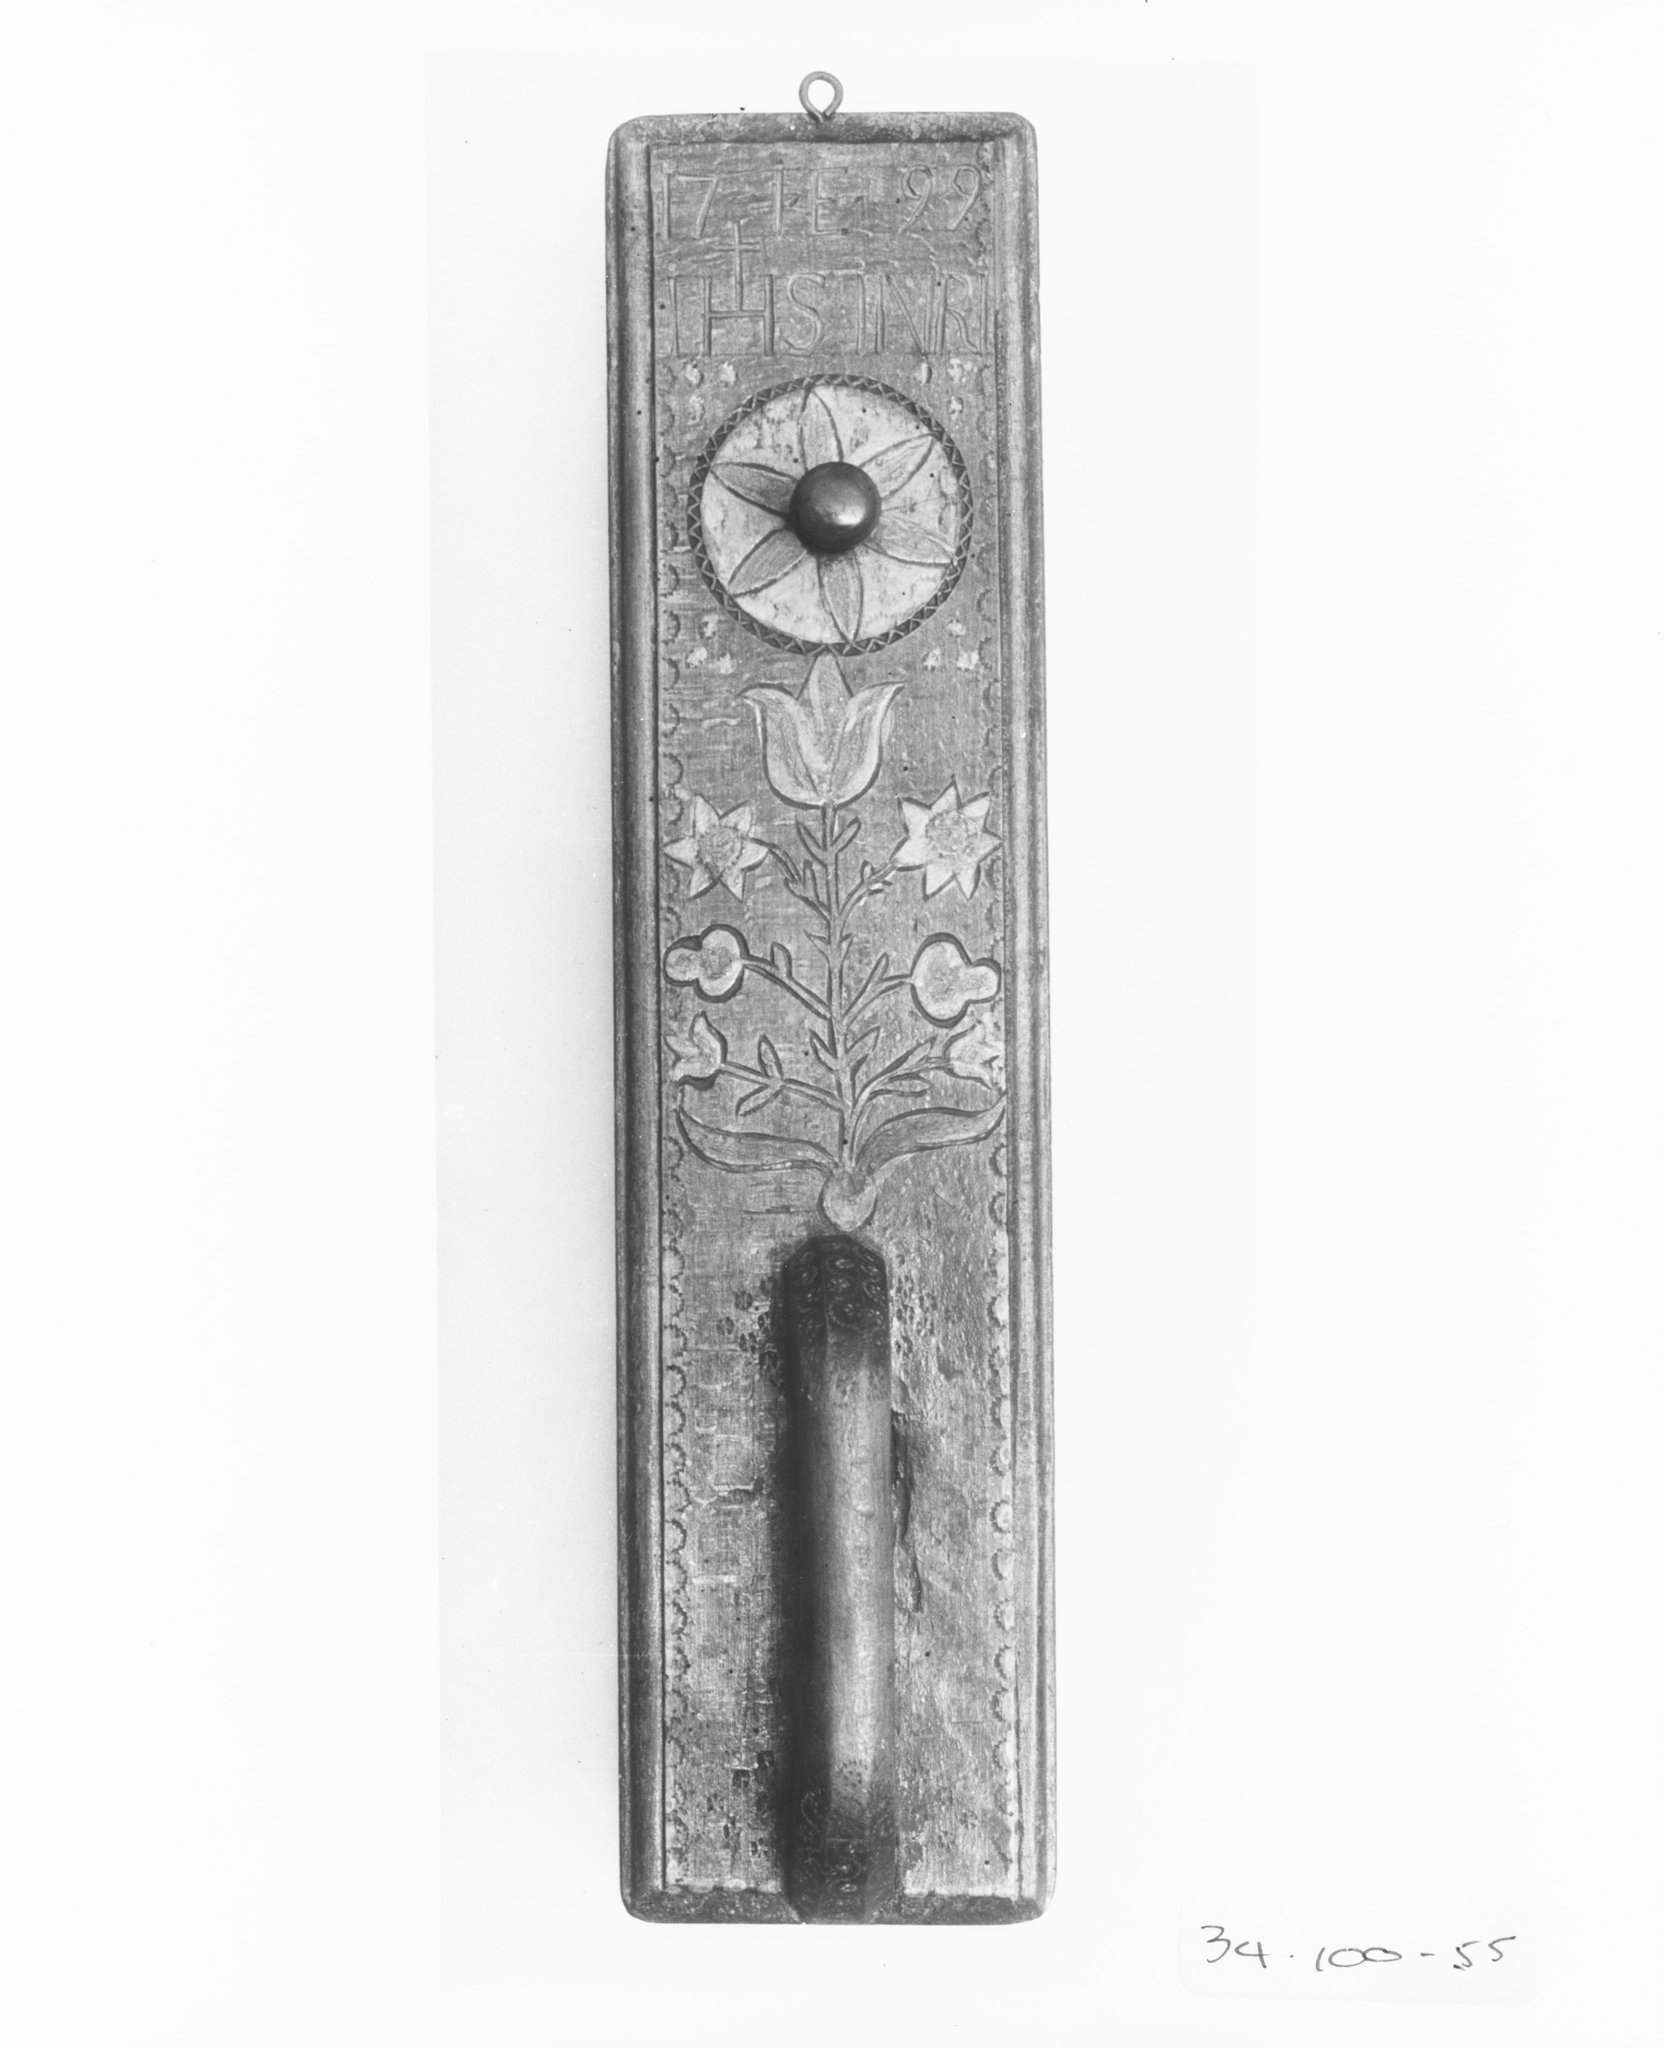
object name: mangle board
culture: european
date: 1799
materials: wood